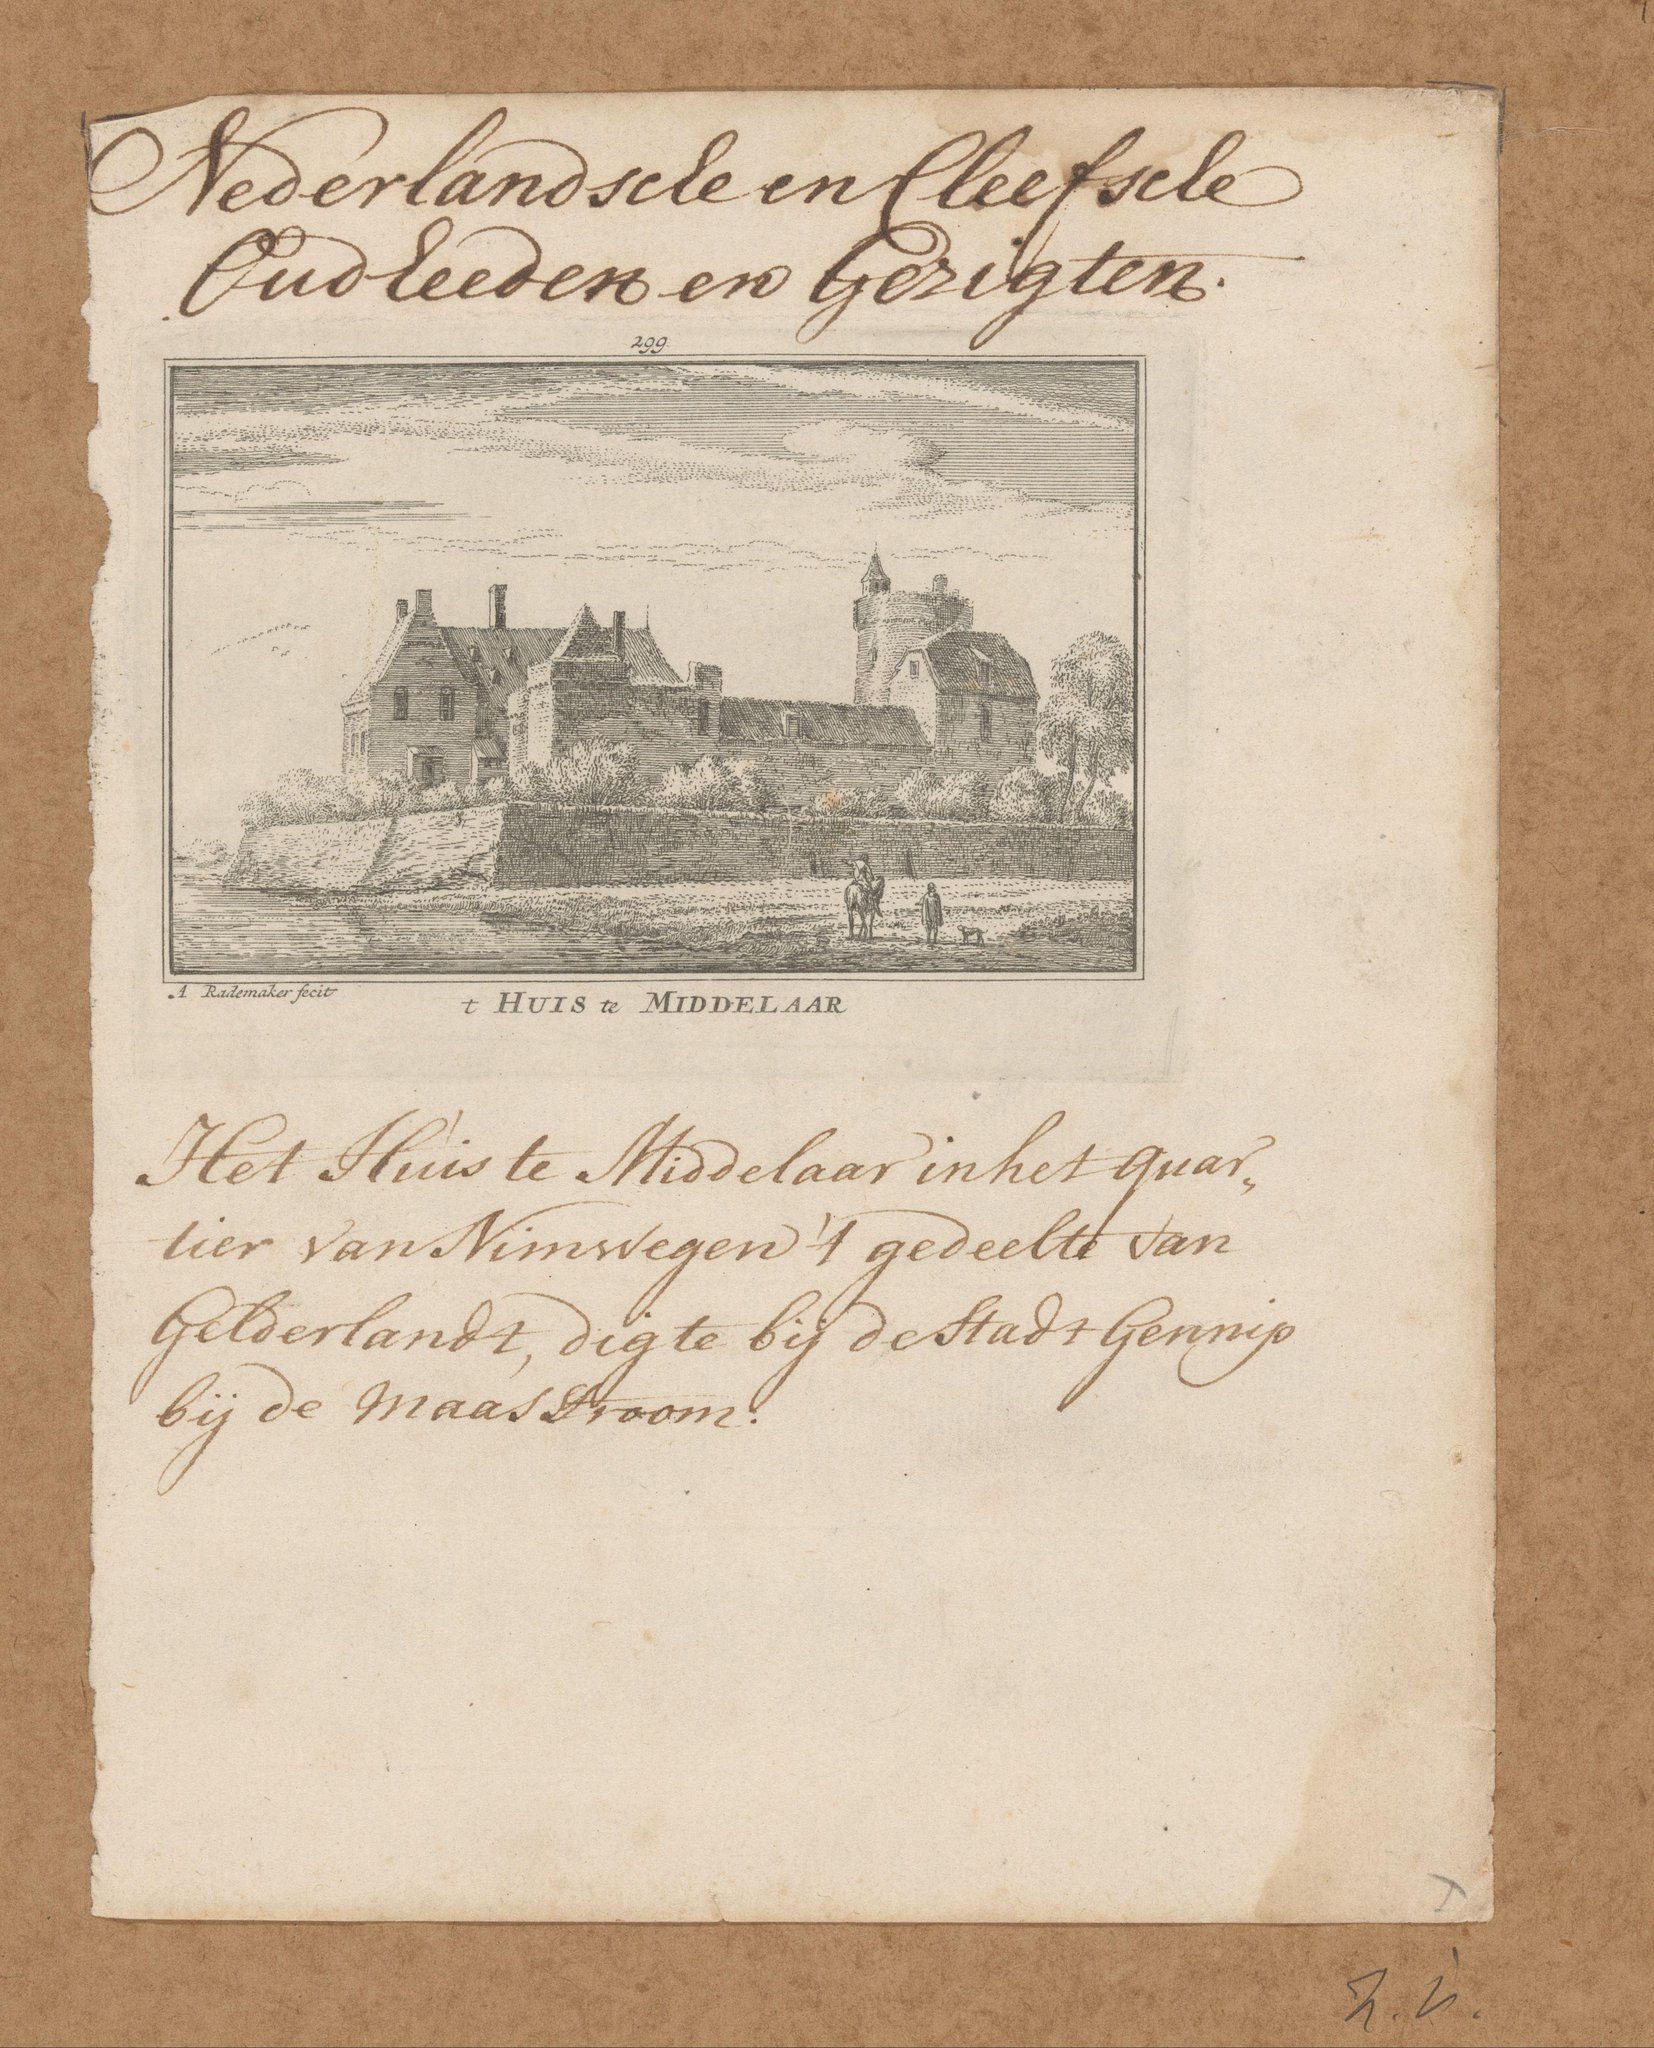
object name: book illustration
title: t Huis te Middelaar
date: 1727-1733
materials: paper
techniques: etching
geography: amsterdam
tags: 'en route', traveller under way, dog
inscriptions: inscription: ‘Nederlandsche en Cleefsche Oudheeden en Gezigten. Het Huis te Middelaar in het quartier van Nimwegen 't gedeelte van Gelderlandt, digte bij de Stadt Gennip bij de Maasstroom’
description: Prent uit: Rademaker, Abraham, en Matthaeus Brouërius van Niedek, en Isaac Le Long. Kabinet van Nederlandsche en Kleefsche outheden en (...) voorname stads- en landgebouwen. Amsterdam: Willem Barents en Antoni Schoonenburg, 1727-1733, ill. nr. 299.